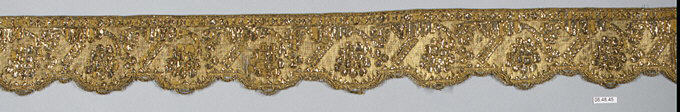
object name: galloon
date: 1701-1800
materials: silk